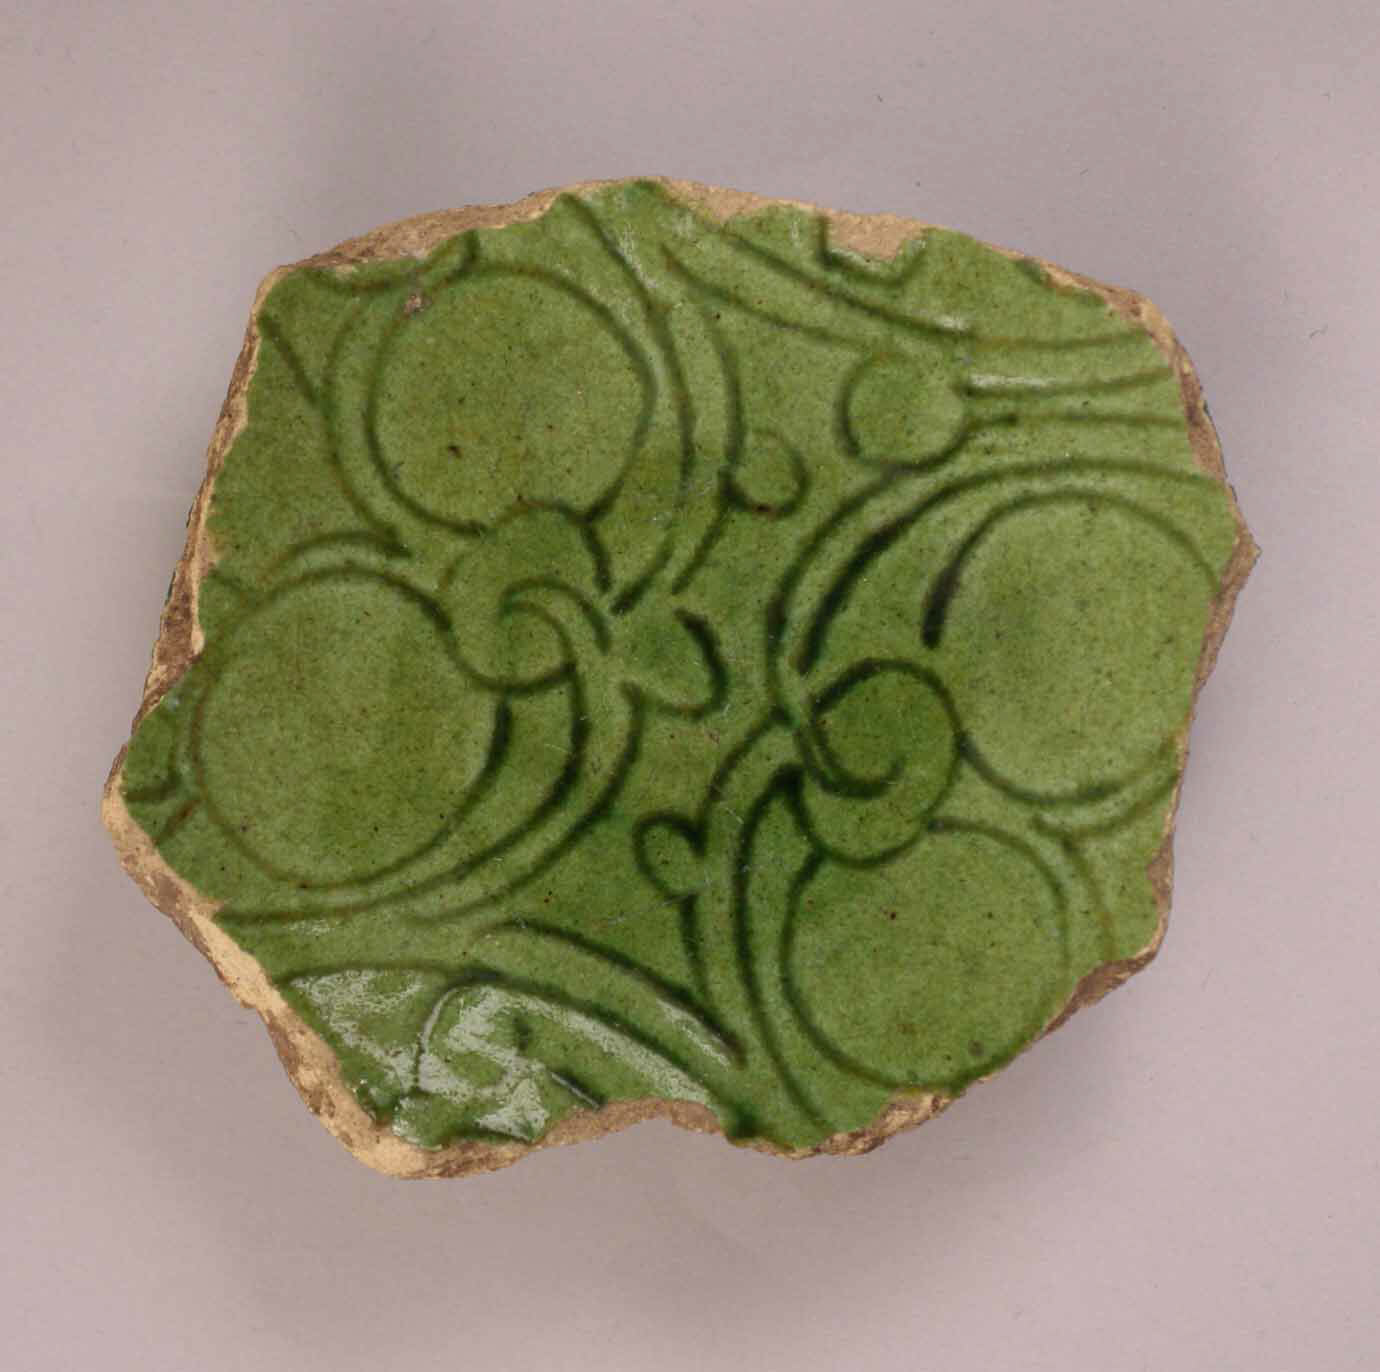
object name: ceramic fragment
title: Fragment of a Bowl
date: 1201-1400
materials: earthenware, glaze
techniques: incising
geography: egypt